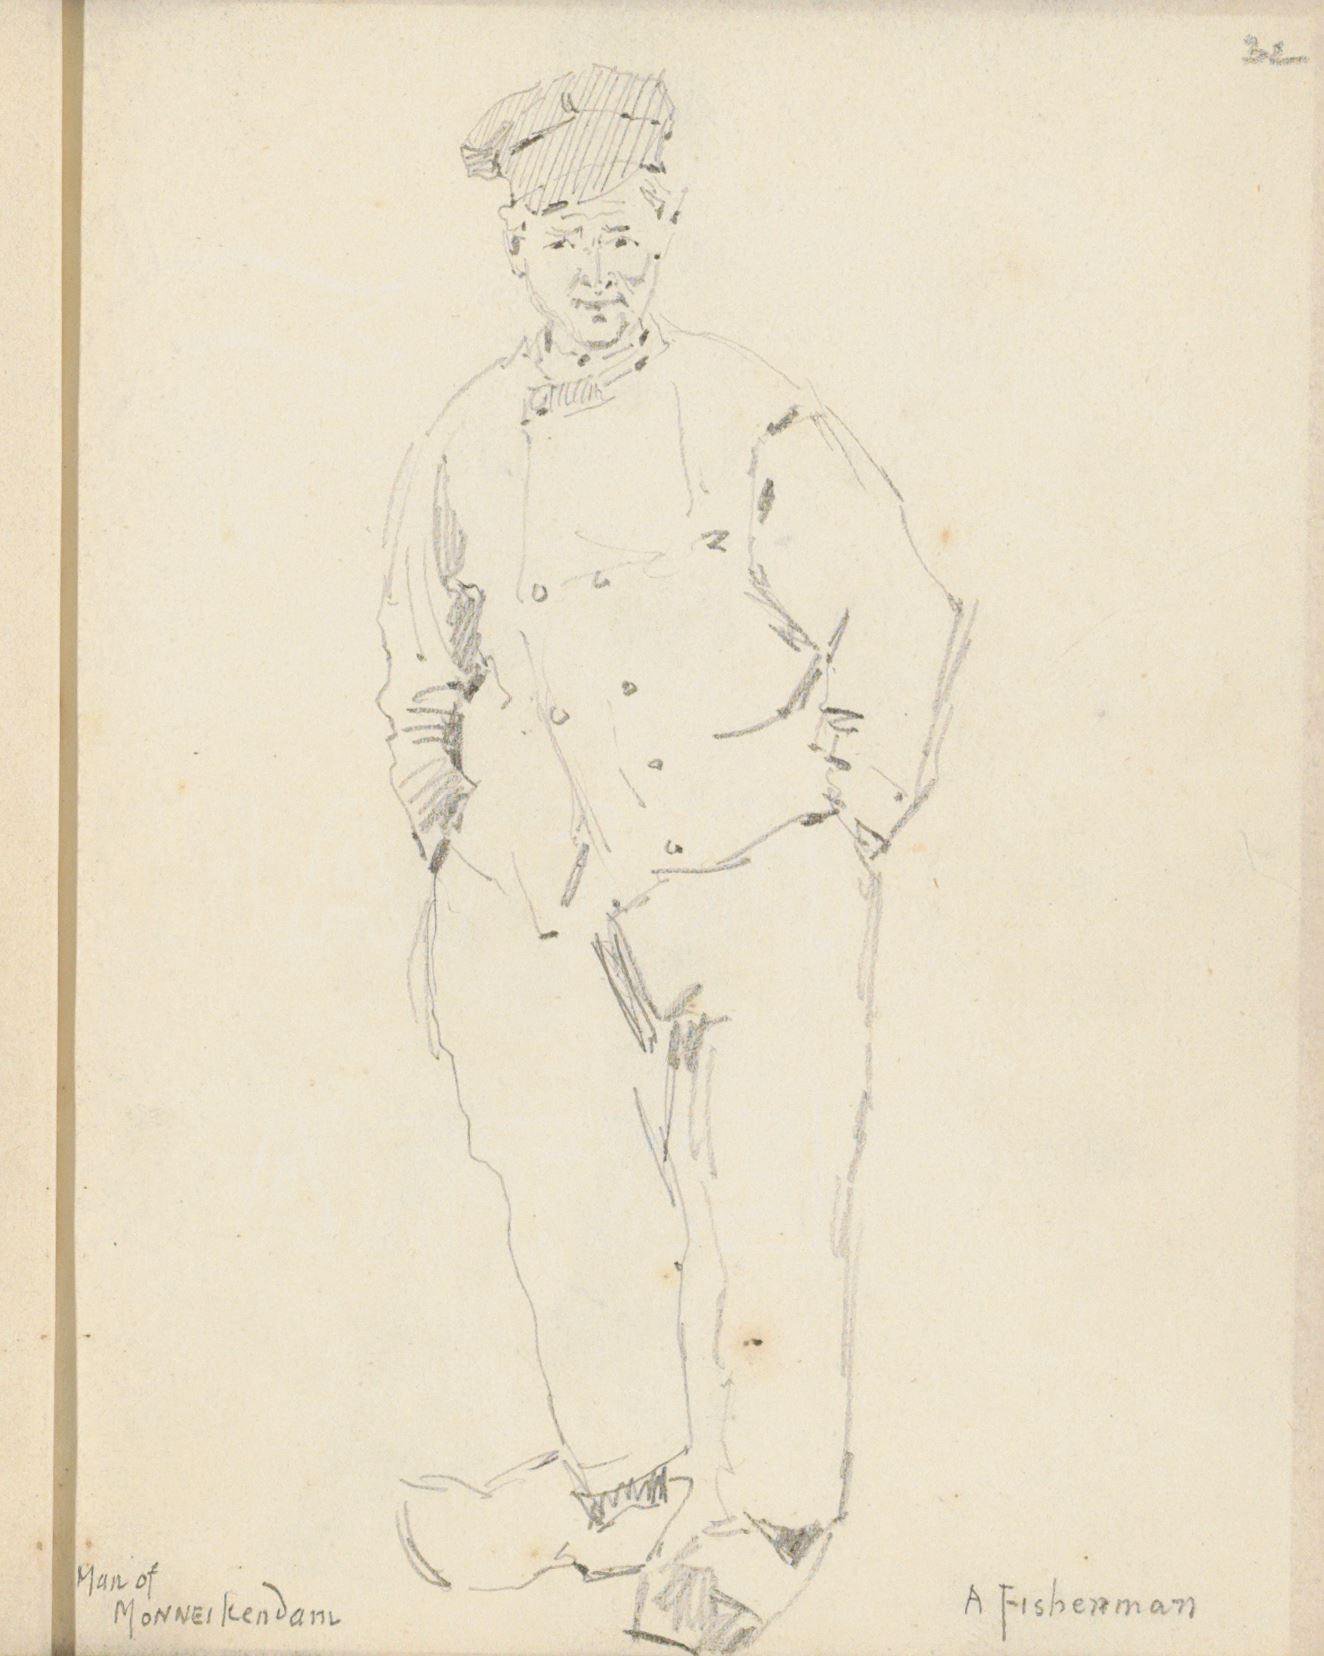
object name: sketchbook leaf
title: Visser uit Monnickendam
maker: alfred william rich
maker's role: draughtsman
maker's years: 1856-1921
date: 1892-1893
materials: paper, pencil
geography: monnickendam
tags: fisherman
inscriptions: annotation: ‘Man of/ Monneikendam/ A Fisherman’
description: Blad 32 recto uit een schetsboek met 86 bladen.